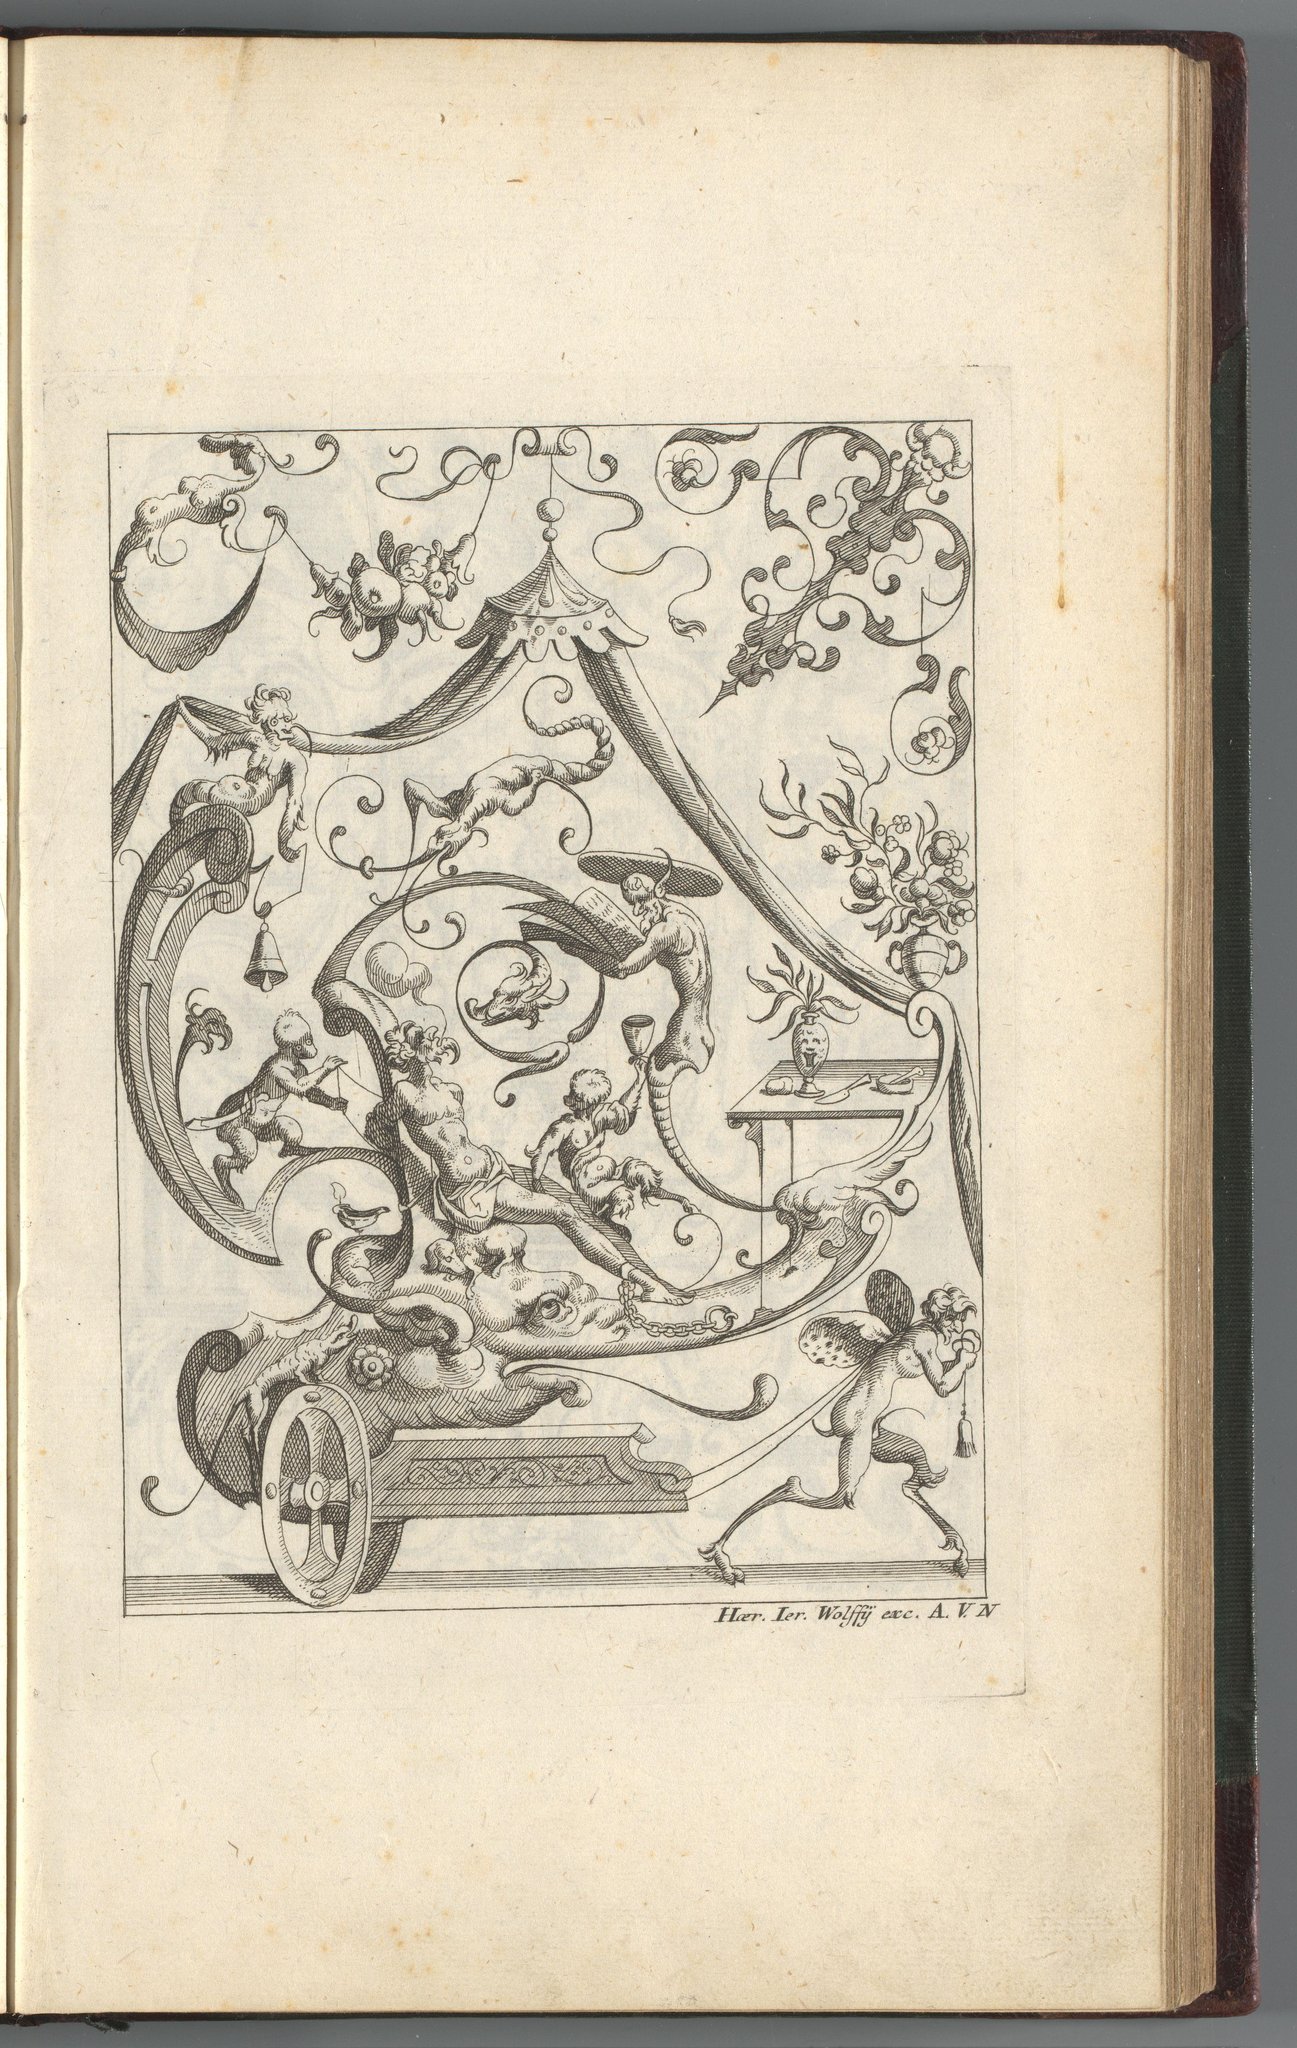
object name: ornament print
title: Compositie met vastgeketende man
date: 1686-1724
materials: paper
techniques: etching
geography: augsburg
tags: ornaments ~ art, satyr(s) (in general), (farm) wagon, freight wagon, cart, tools, aids, implements ~ crafts and industries: chain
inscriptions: signature: ‘Ier. Wolffij exc. A. V. N.’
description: Een compositie van een vastgekentende man op een kar in de vorm van een olifantenkop, voortgetrokken door een satyr. De man wordt toegesproken door een mythisch figuur die ergens uit voorleest en van bovenaf wordt de man belaagd door een schorpioenachtig wezen. Prent maakt deel uit van een album. Hoogstwaarschijnlijk gespiegelde kopie naar Frans origineel.